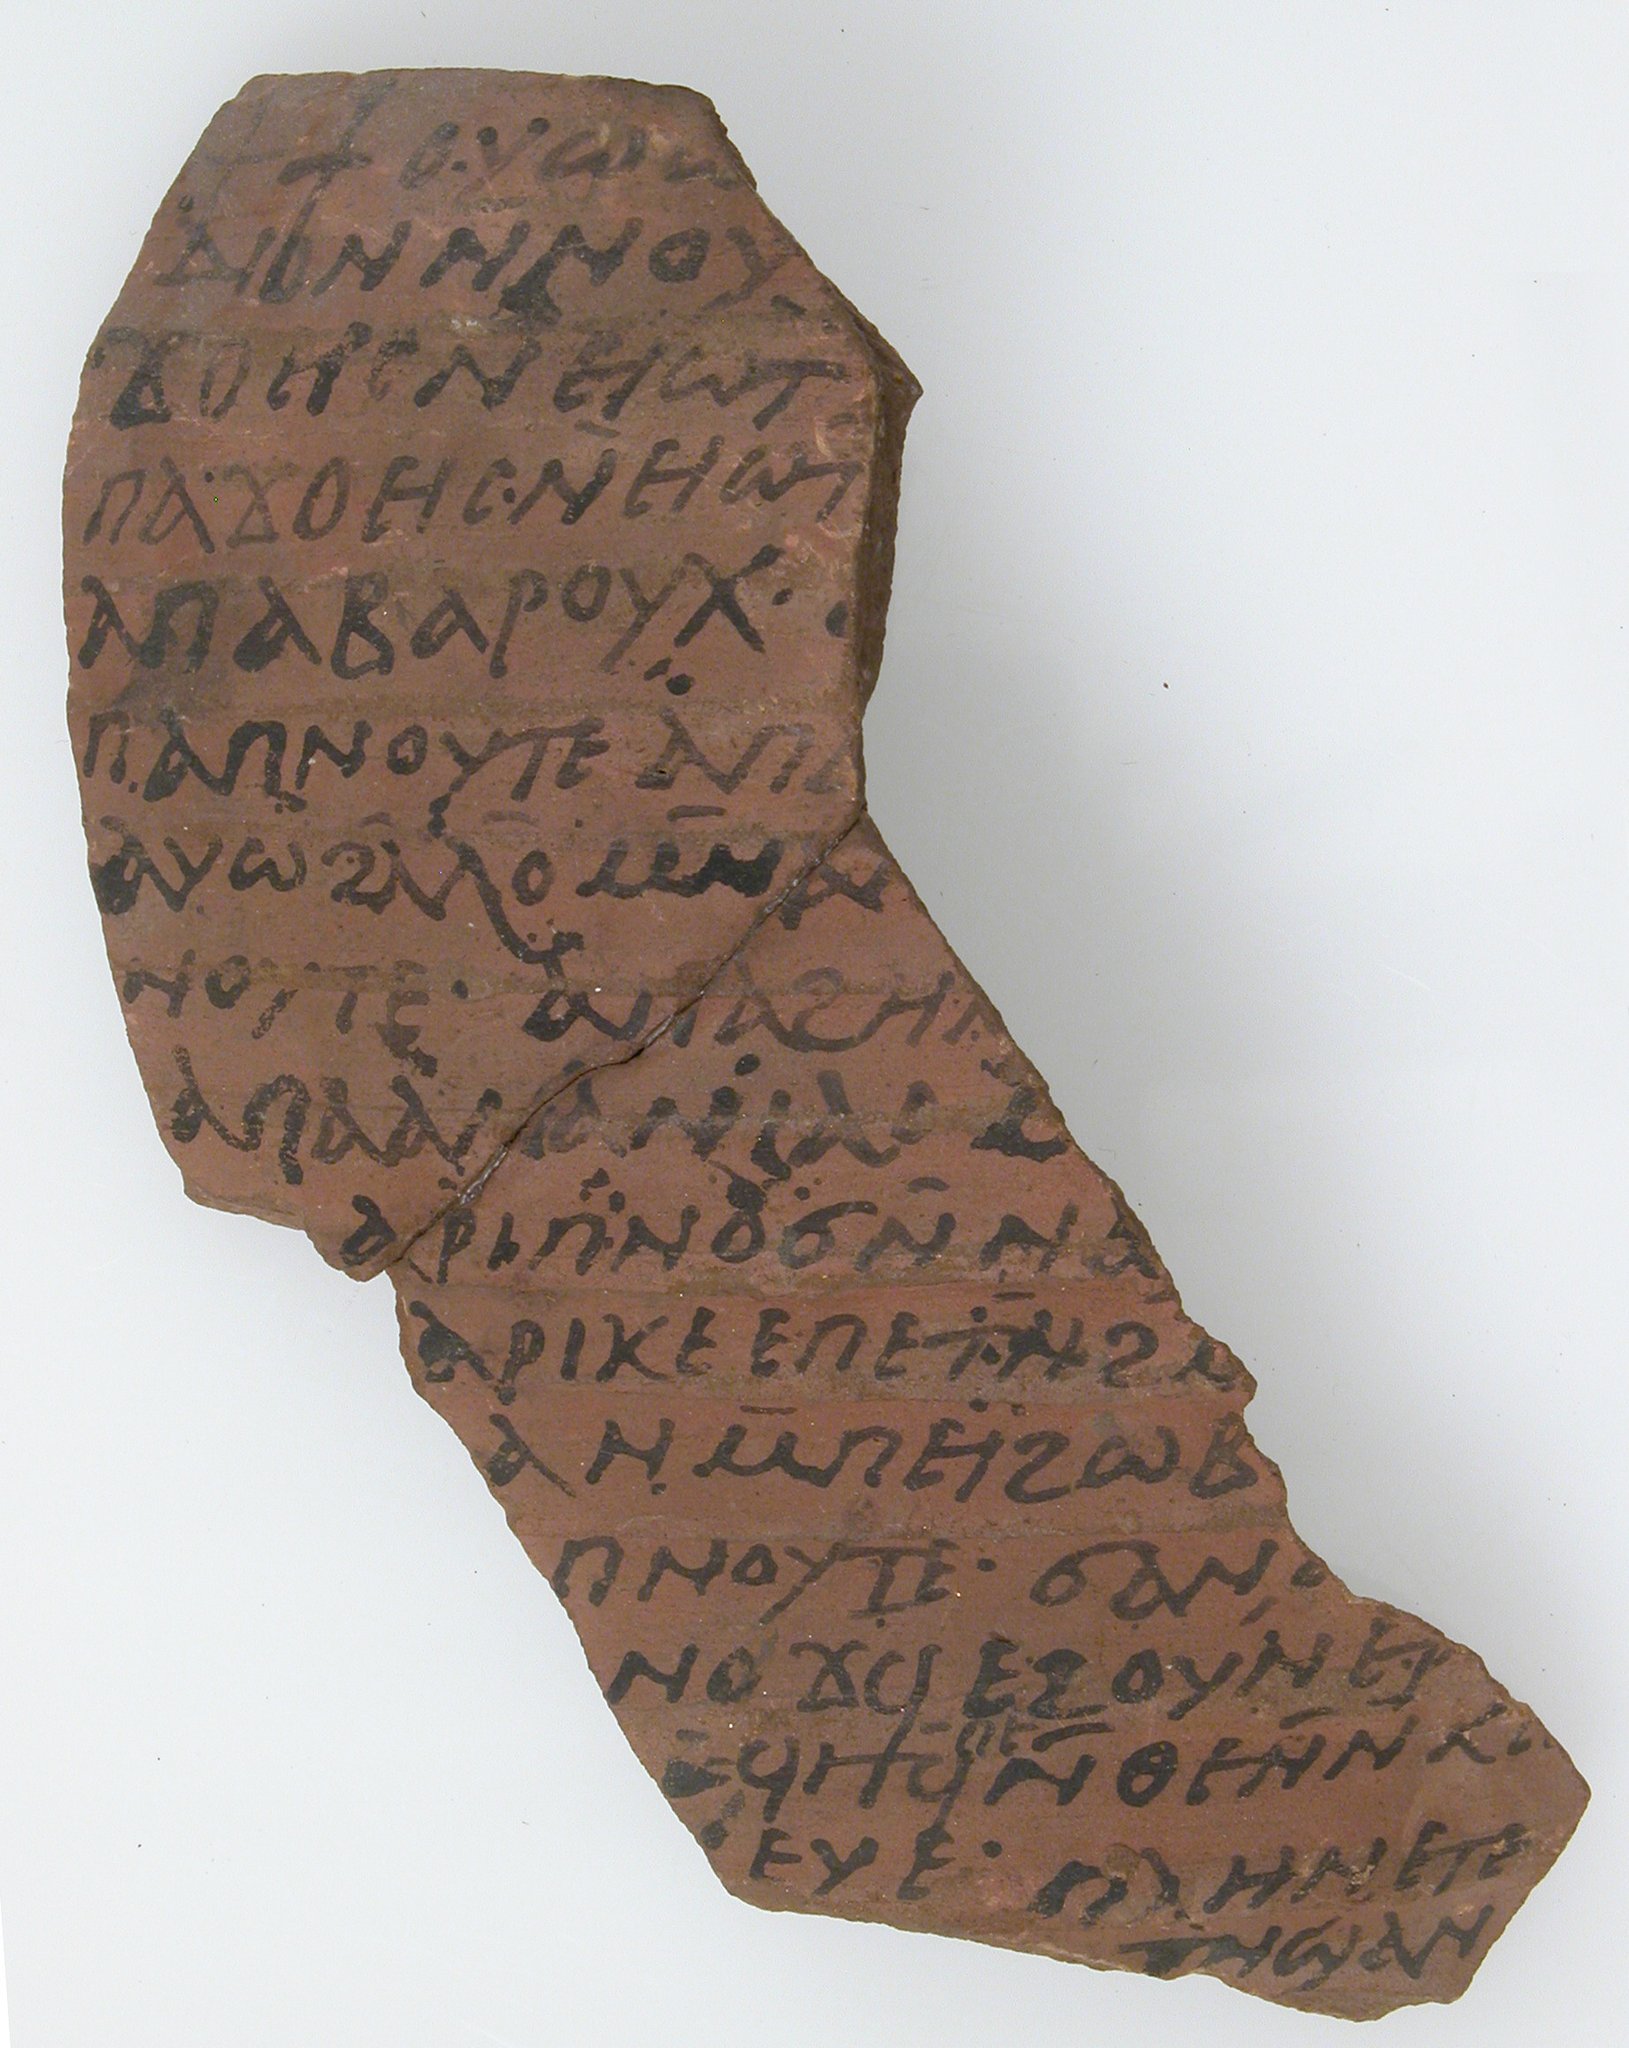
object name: ostrakon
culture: coptic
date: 601-700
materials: ink, pottery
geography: egypt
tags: coptic,documents